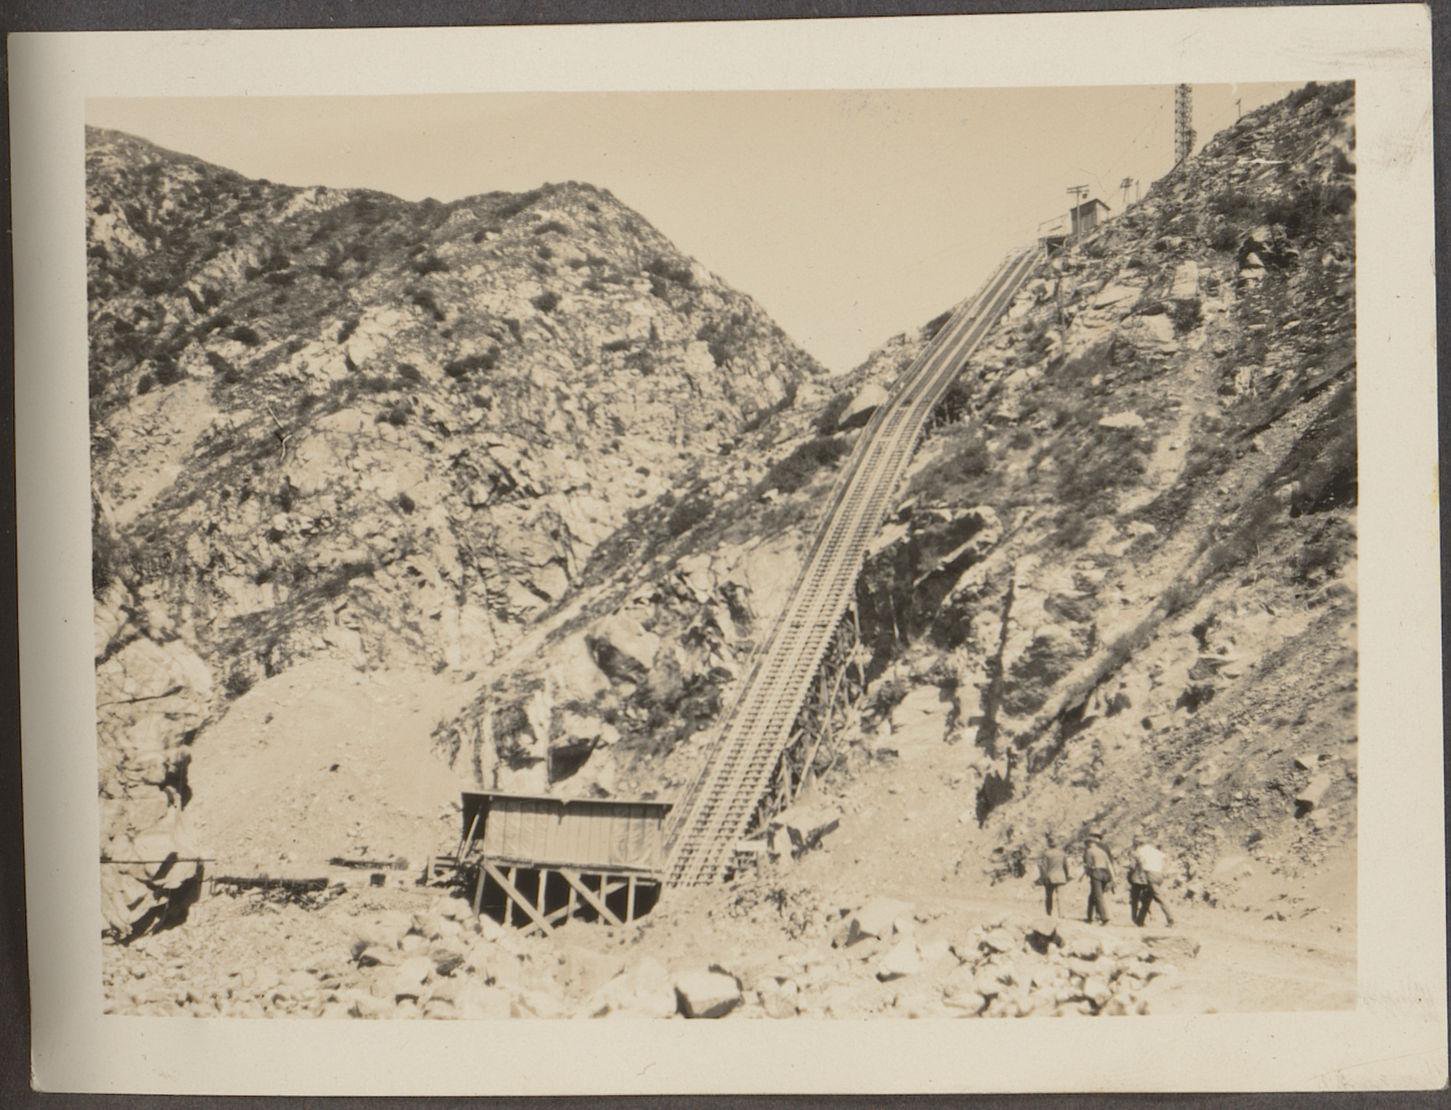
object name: album leaf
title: Pacoima Dam in aanbouw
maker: Anonymous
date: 1928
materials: photographic support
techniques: gelatin silver print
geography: los angeles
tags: machines; parts of machines; tools and appliances, dam (in canal)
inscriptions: annotation: ‘Pacoima dam beton transportbaan’